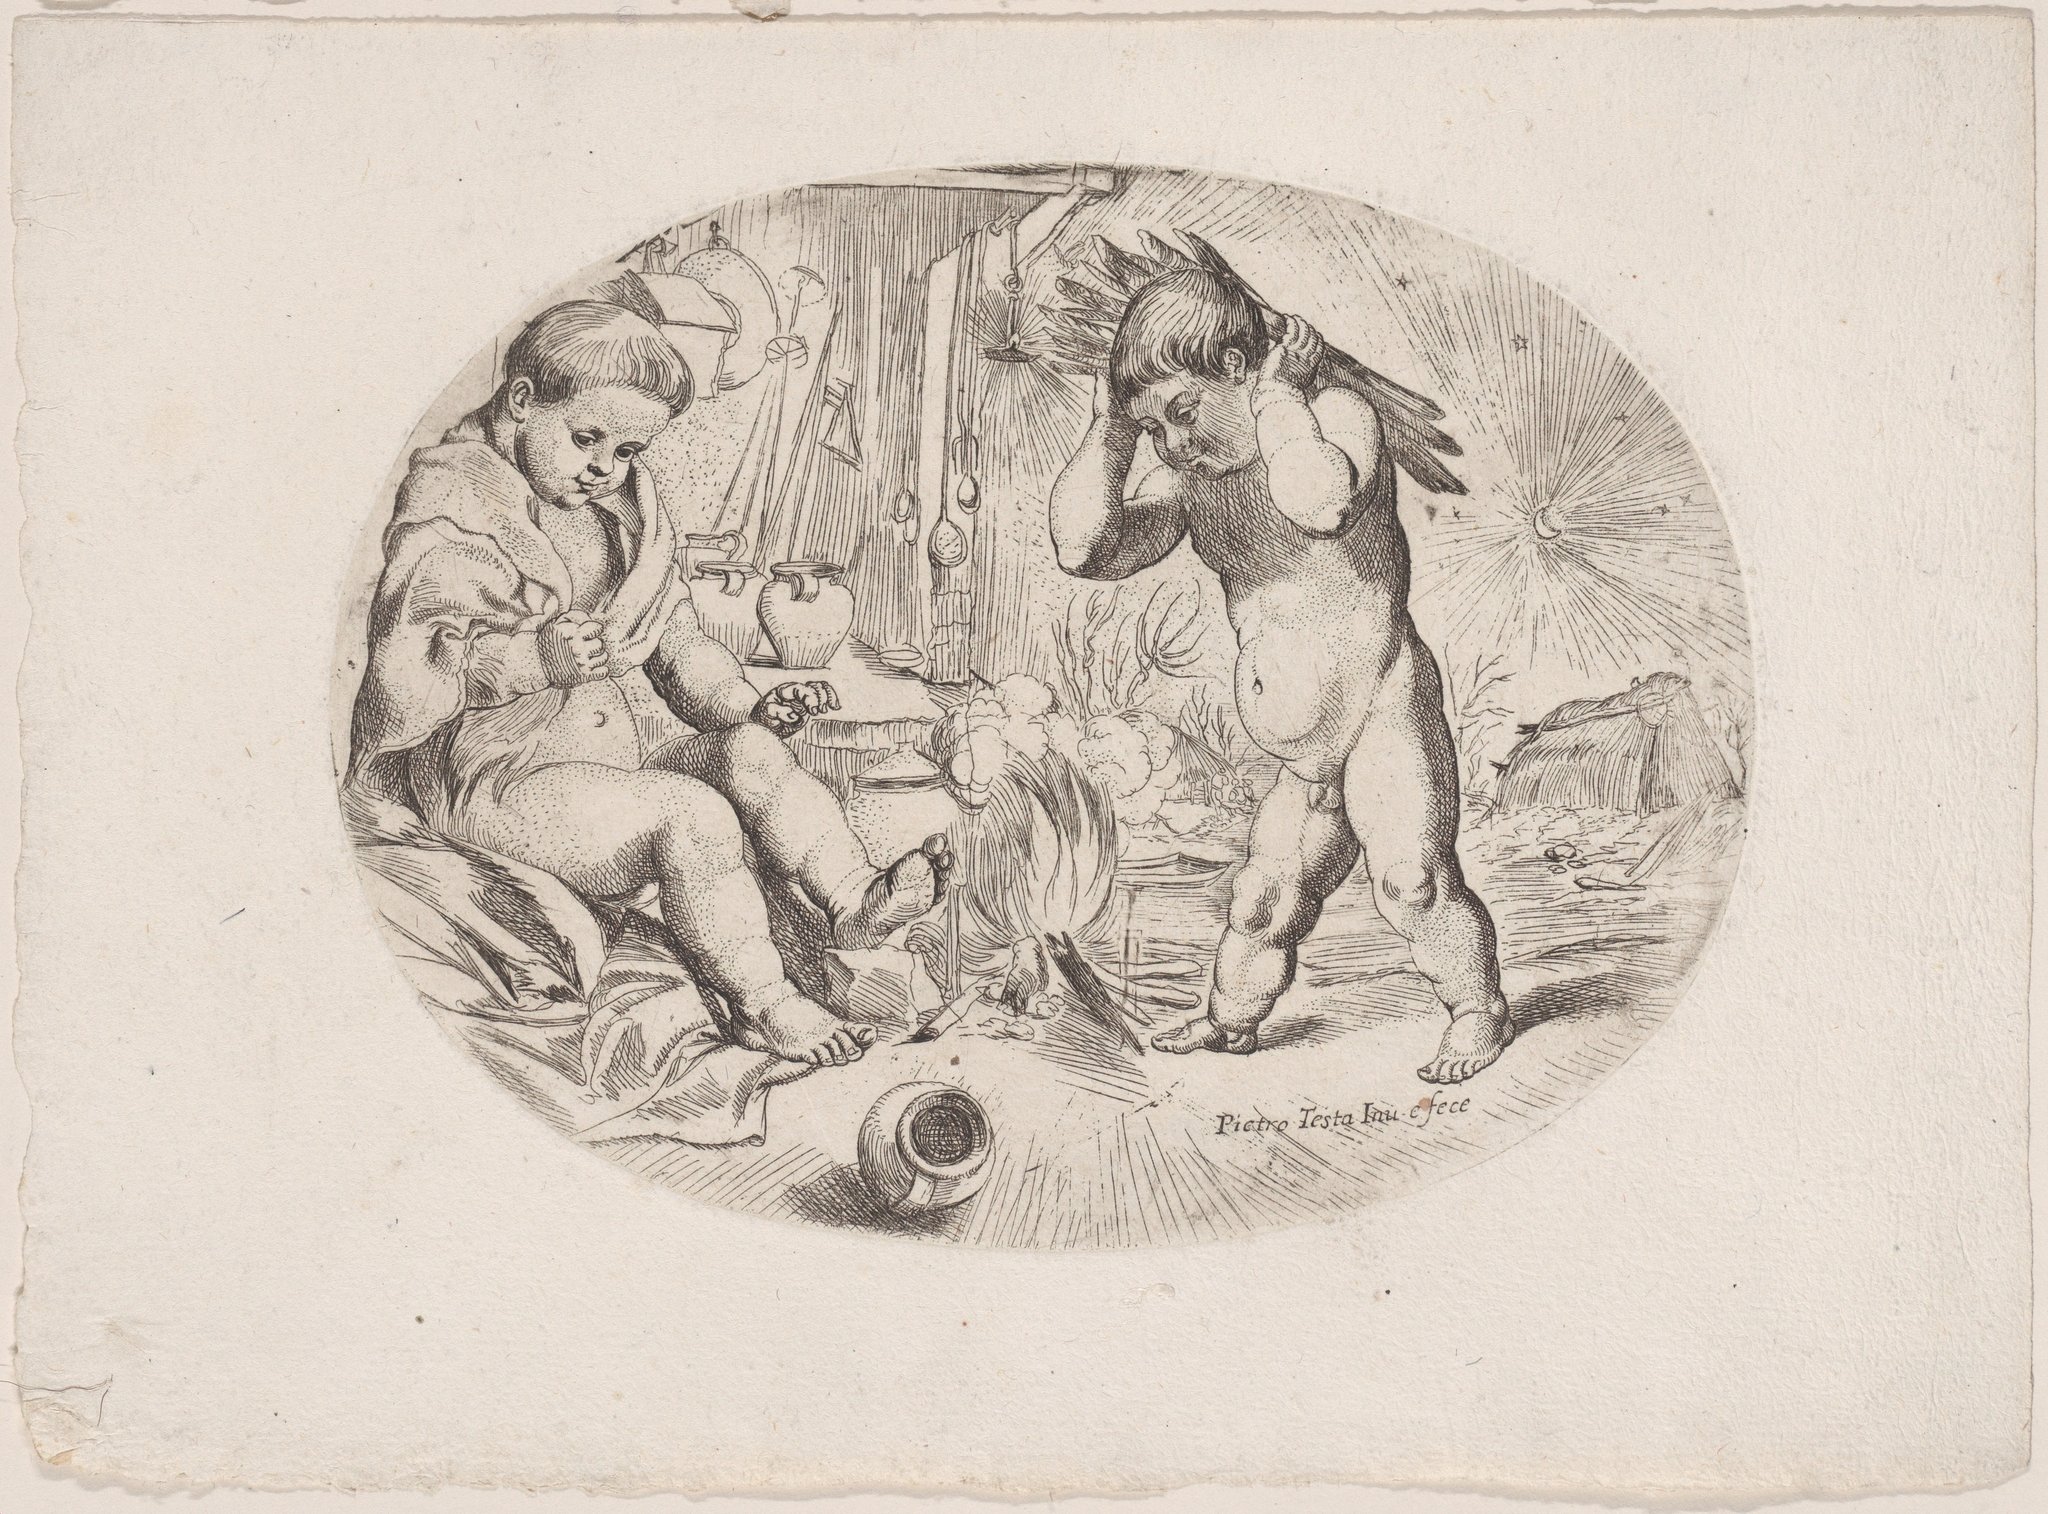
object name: print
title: Putto at left by a fire, anther at right carrying wood, an allegory of the seasons (Winter) an oval composition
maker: anonymous, 17th century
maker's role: artist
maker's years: 1600-1700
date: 1650-1680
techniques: etching